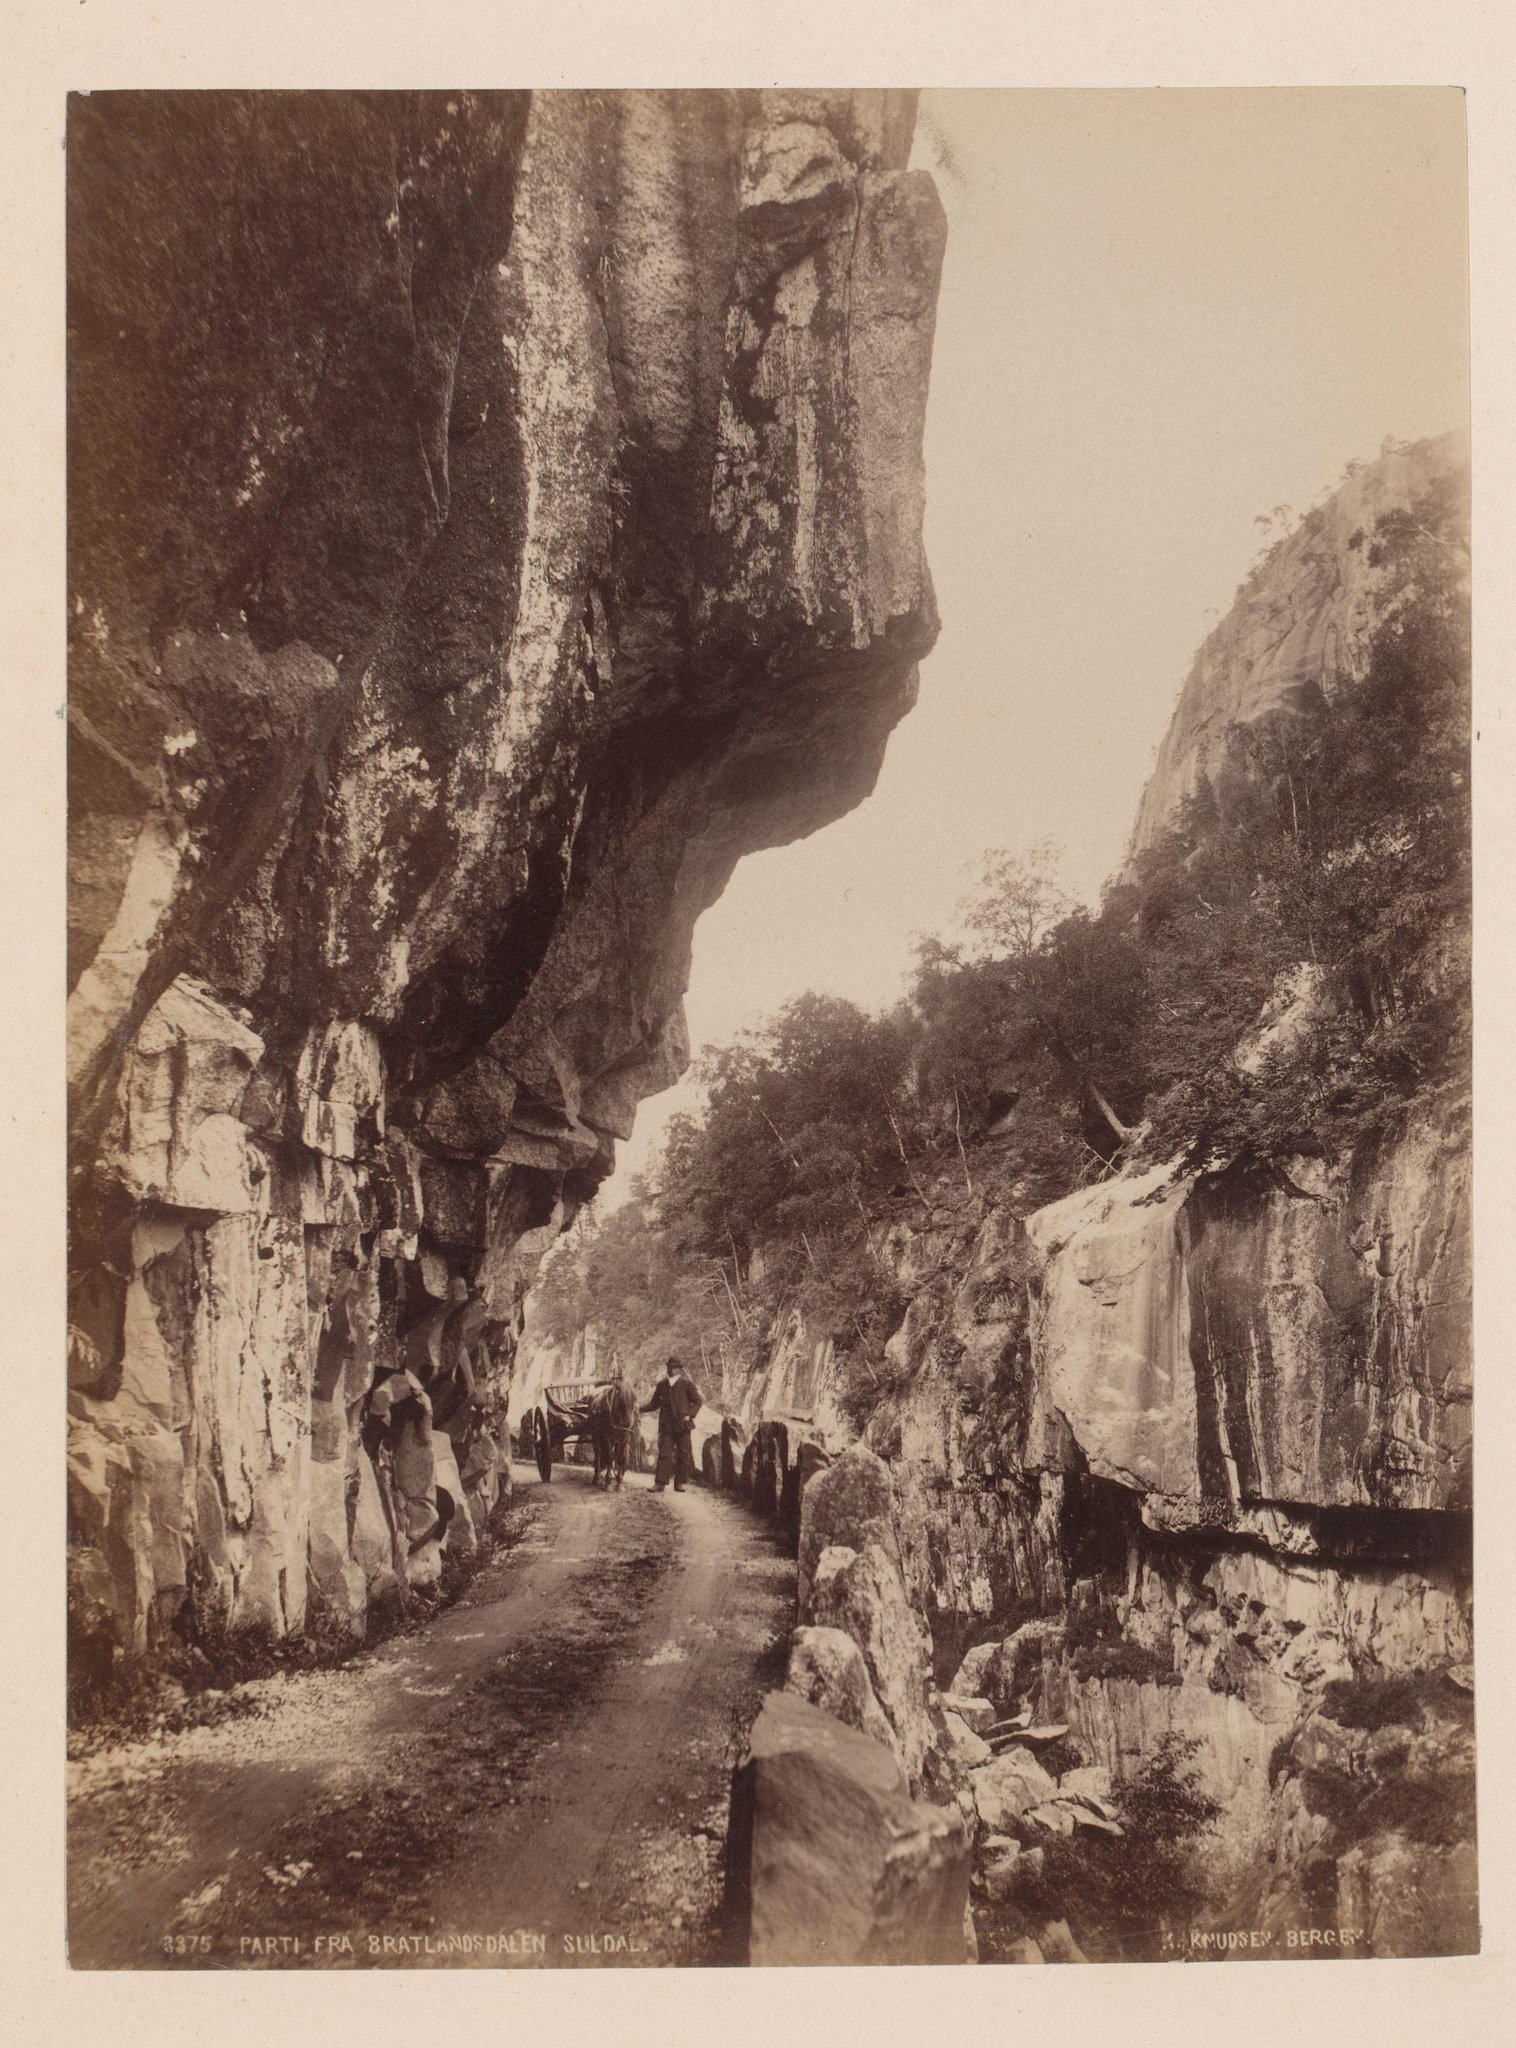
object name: photograph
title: Parti fra Bratlandsdalen, Suldal, Noorwegen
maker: knud knudsen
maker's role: fotograaf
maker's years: 1832-1915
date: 1870-1900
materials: cardboard, photographic support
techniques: albumen print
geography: norway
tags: norway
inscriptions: caption: ‘3375 PARTI FRA BRATLANDSDALEN SULDAL’, number: ‘K. Knudsen, Bergen’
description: Overhangende rots met daaronder een weg met een man met paard en wagen. Rechts een diepe kloof. Suldal is een gemeente in de Noorse provincie Rogaland.